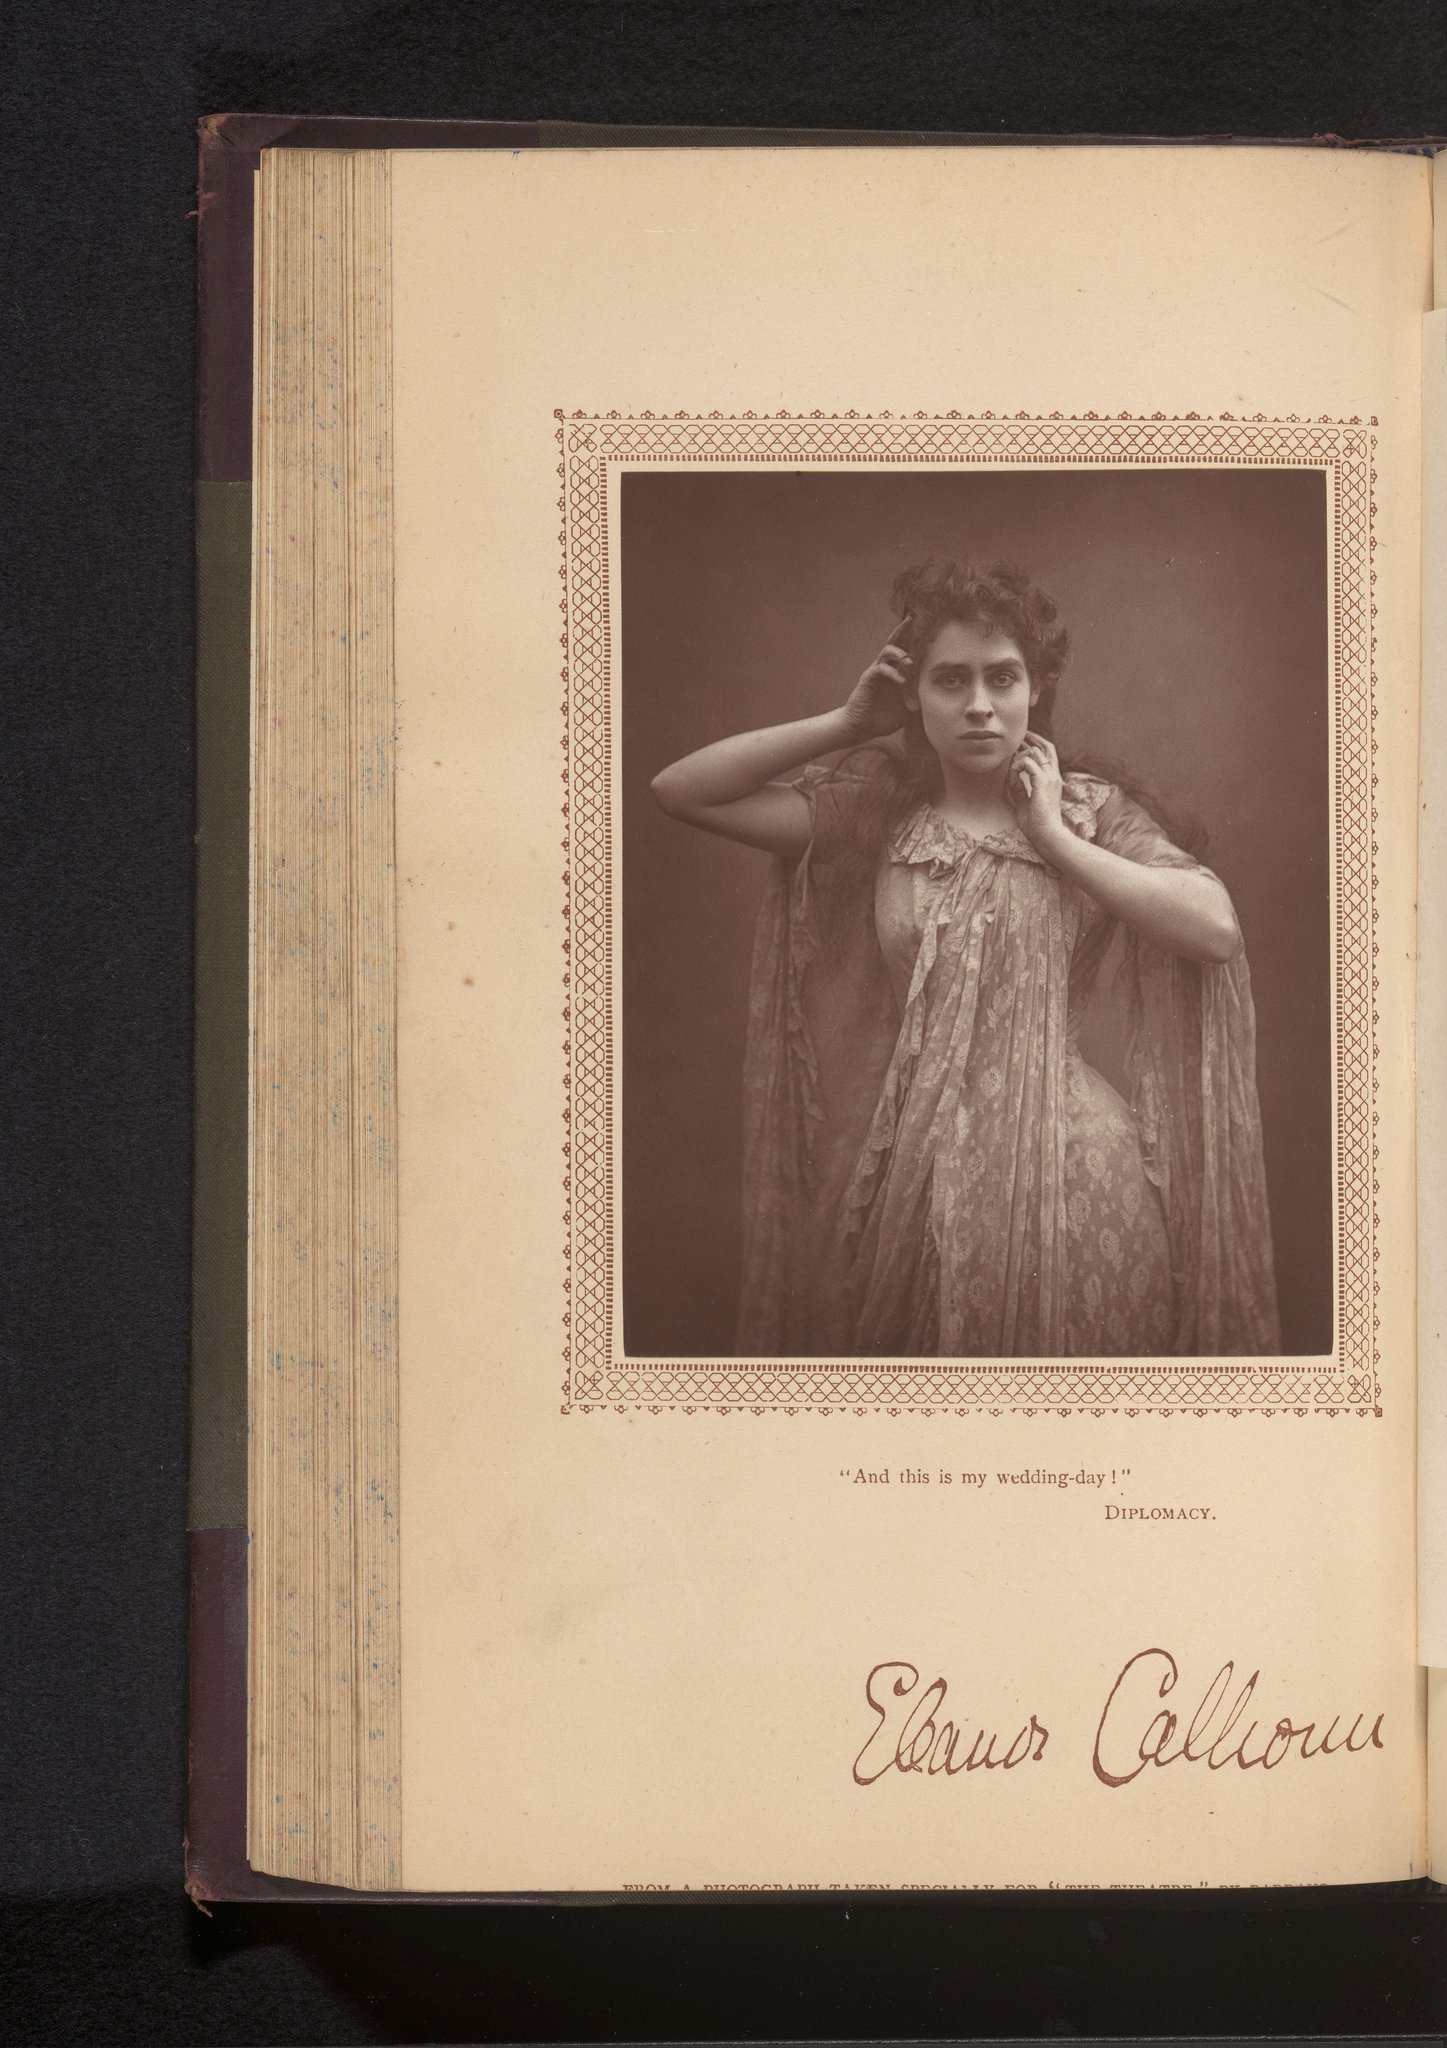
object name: page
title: Portret van Miss Calhoun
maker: Anonymous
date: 1880-1885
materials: paper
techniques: woodburytype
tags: adult man, historical persons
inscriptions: signature: ‘[...] Calhoun’, inscription: ‘'And this is my wedding-day!'/ Diplomacy’